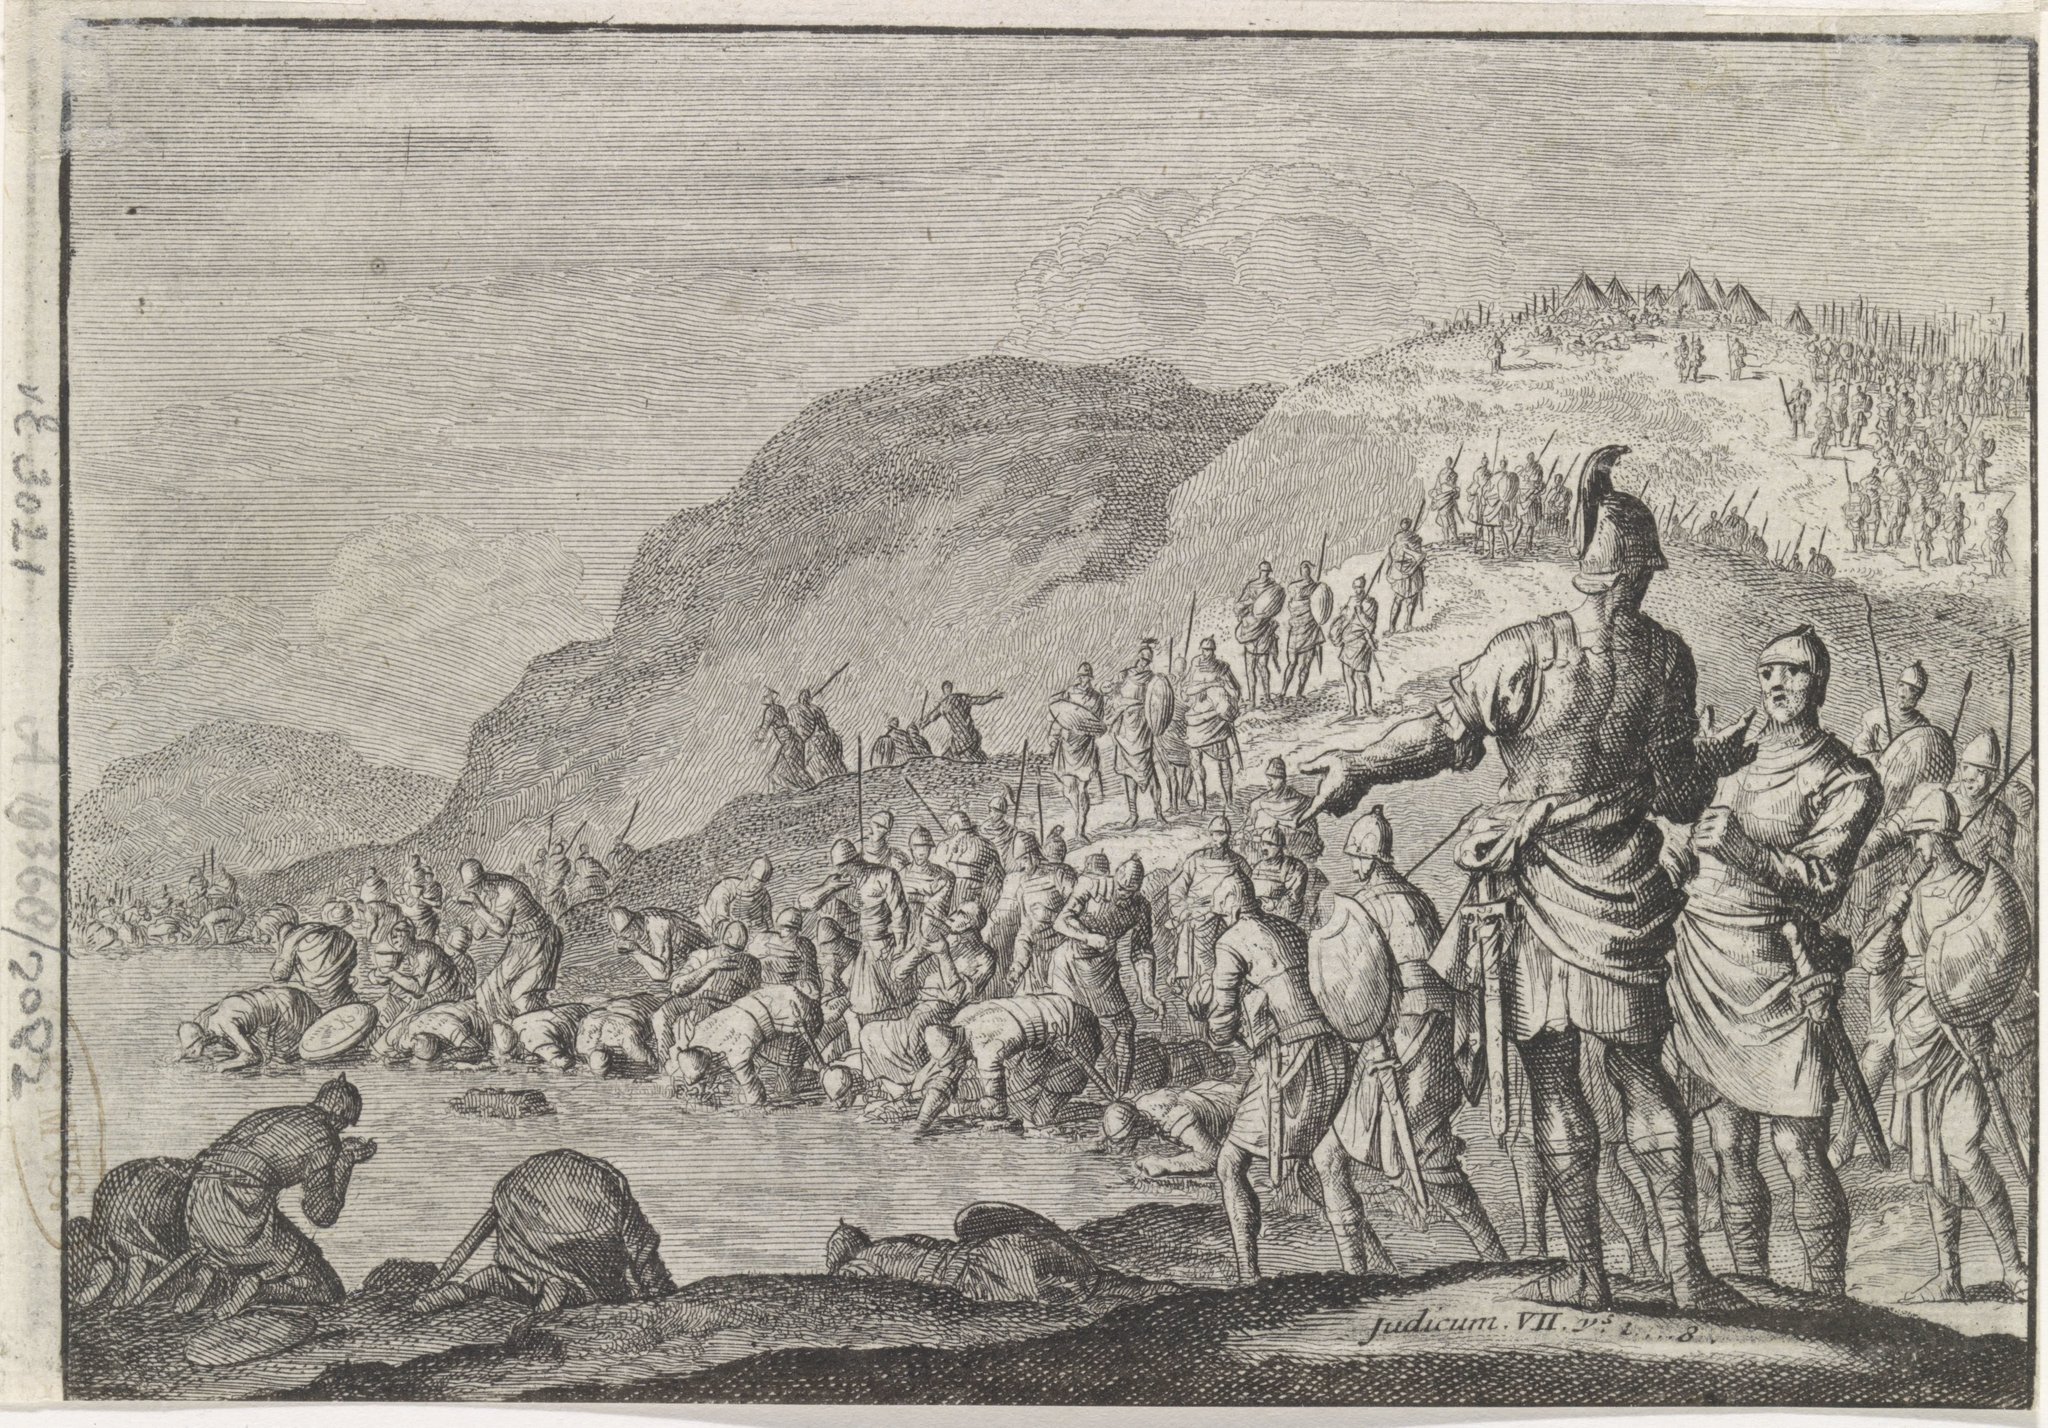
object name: book illustration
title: Gideon beveelt zijn manschappen water te drinken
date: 1703-1762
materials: paper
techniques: etching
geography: haarlem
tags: those who lap water by putting their hand to their mouth are separated from those who kneel down to drink the water ~ selection of gideon's men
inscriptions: collector's mark: Lugt 2228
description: De prent komt een eerste keer voor als boekillustratie voor David Martin. Historie des Ouden en Nieuwen Testaments. Amsterdam, Pieter Mortier, 1703. Deel I. De boekillustraties voor de Mortierbijbel hebben verschillende staten en kopieën, waarbij de chronologische volgorde moeilijk te achterhalen valt. Als boekillustraties werden ze bovendien herhaaldelijk opnieuw gebruikt voor andere boekwerken.